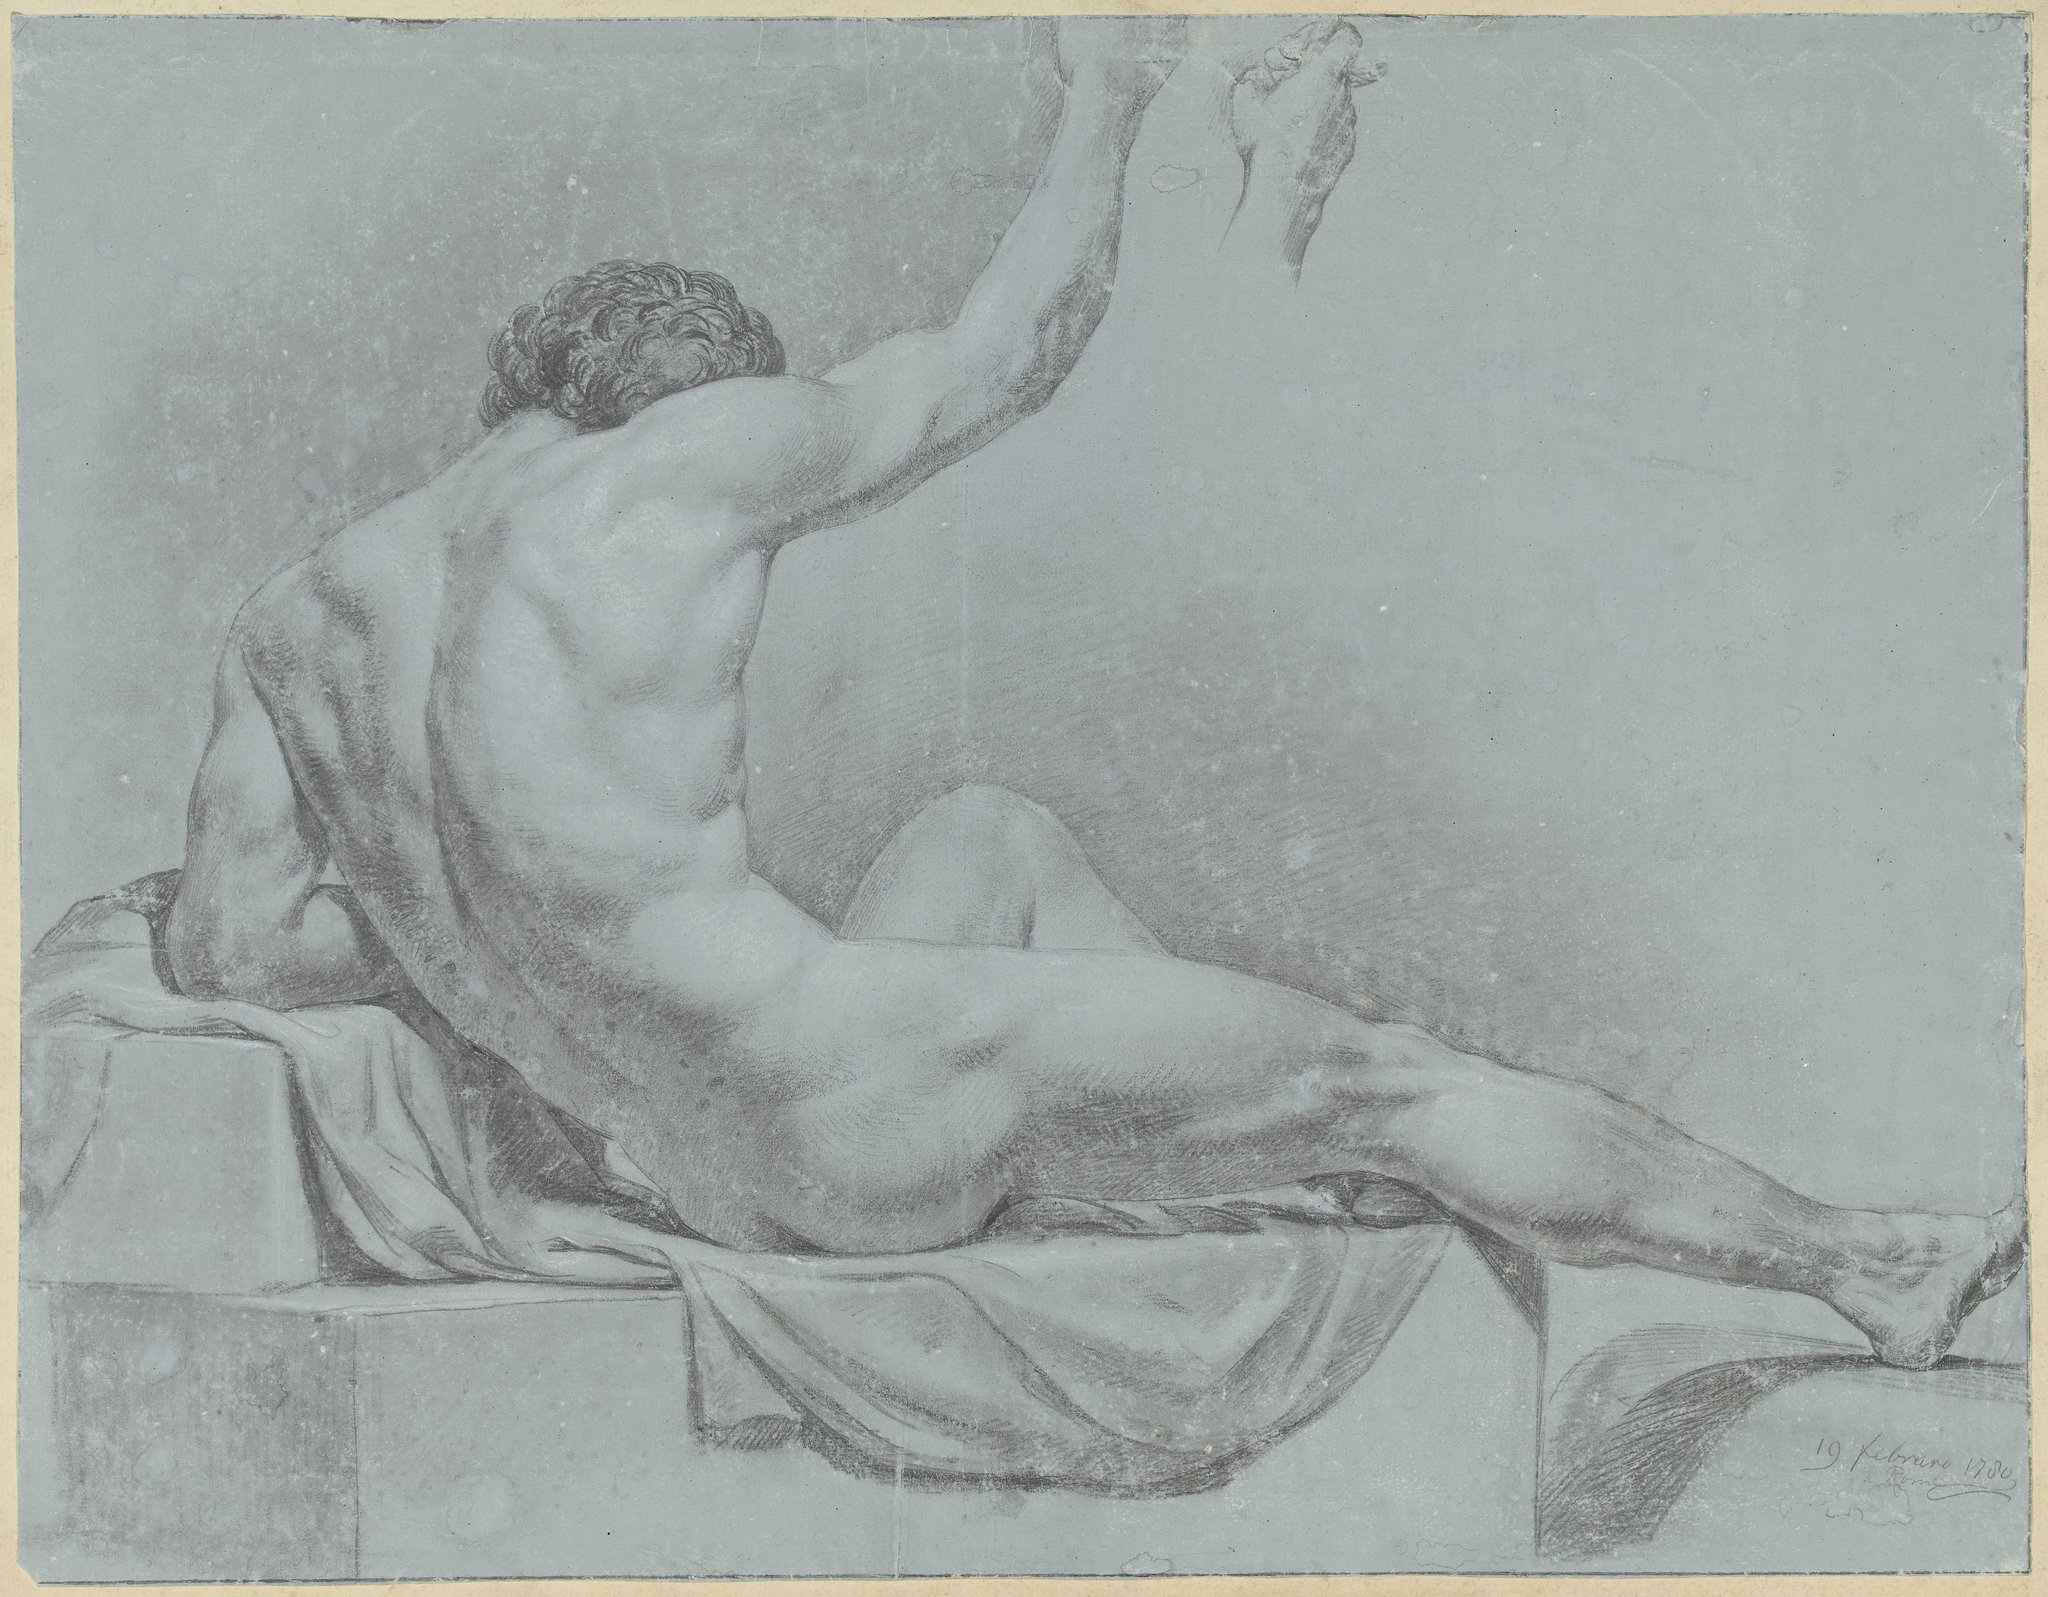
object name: drawing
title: Liggend mannelijk naakt, half opzittend geleund op de linkerarm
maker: jean grandjean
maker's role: draughtsman, print maker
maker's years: 1752-1781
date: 1780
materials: chalk, paper